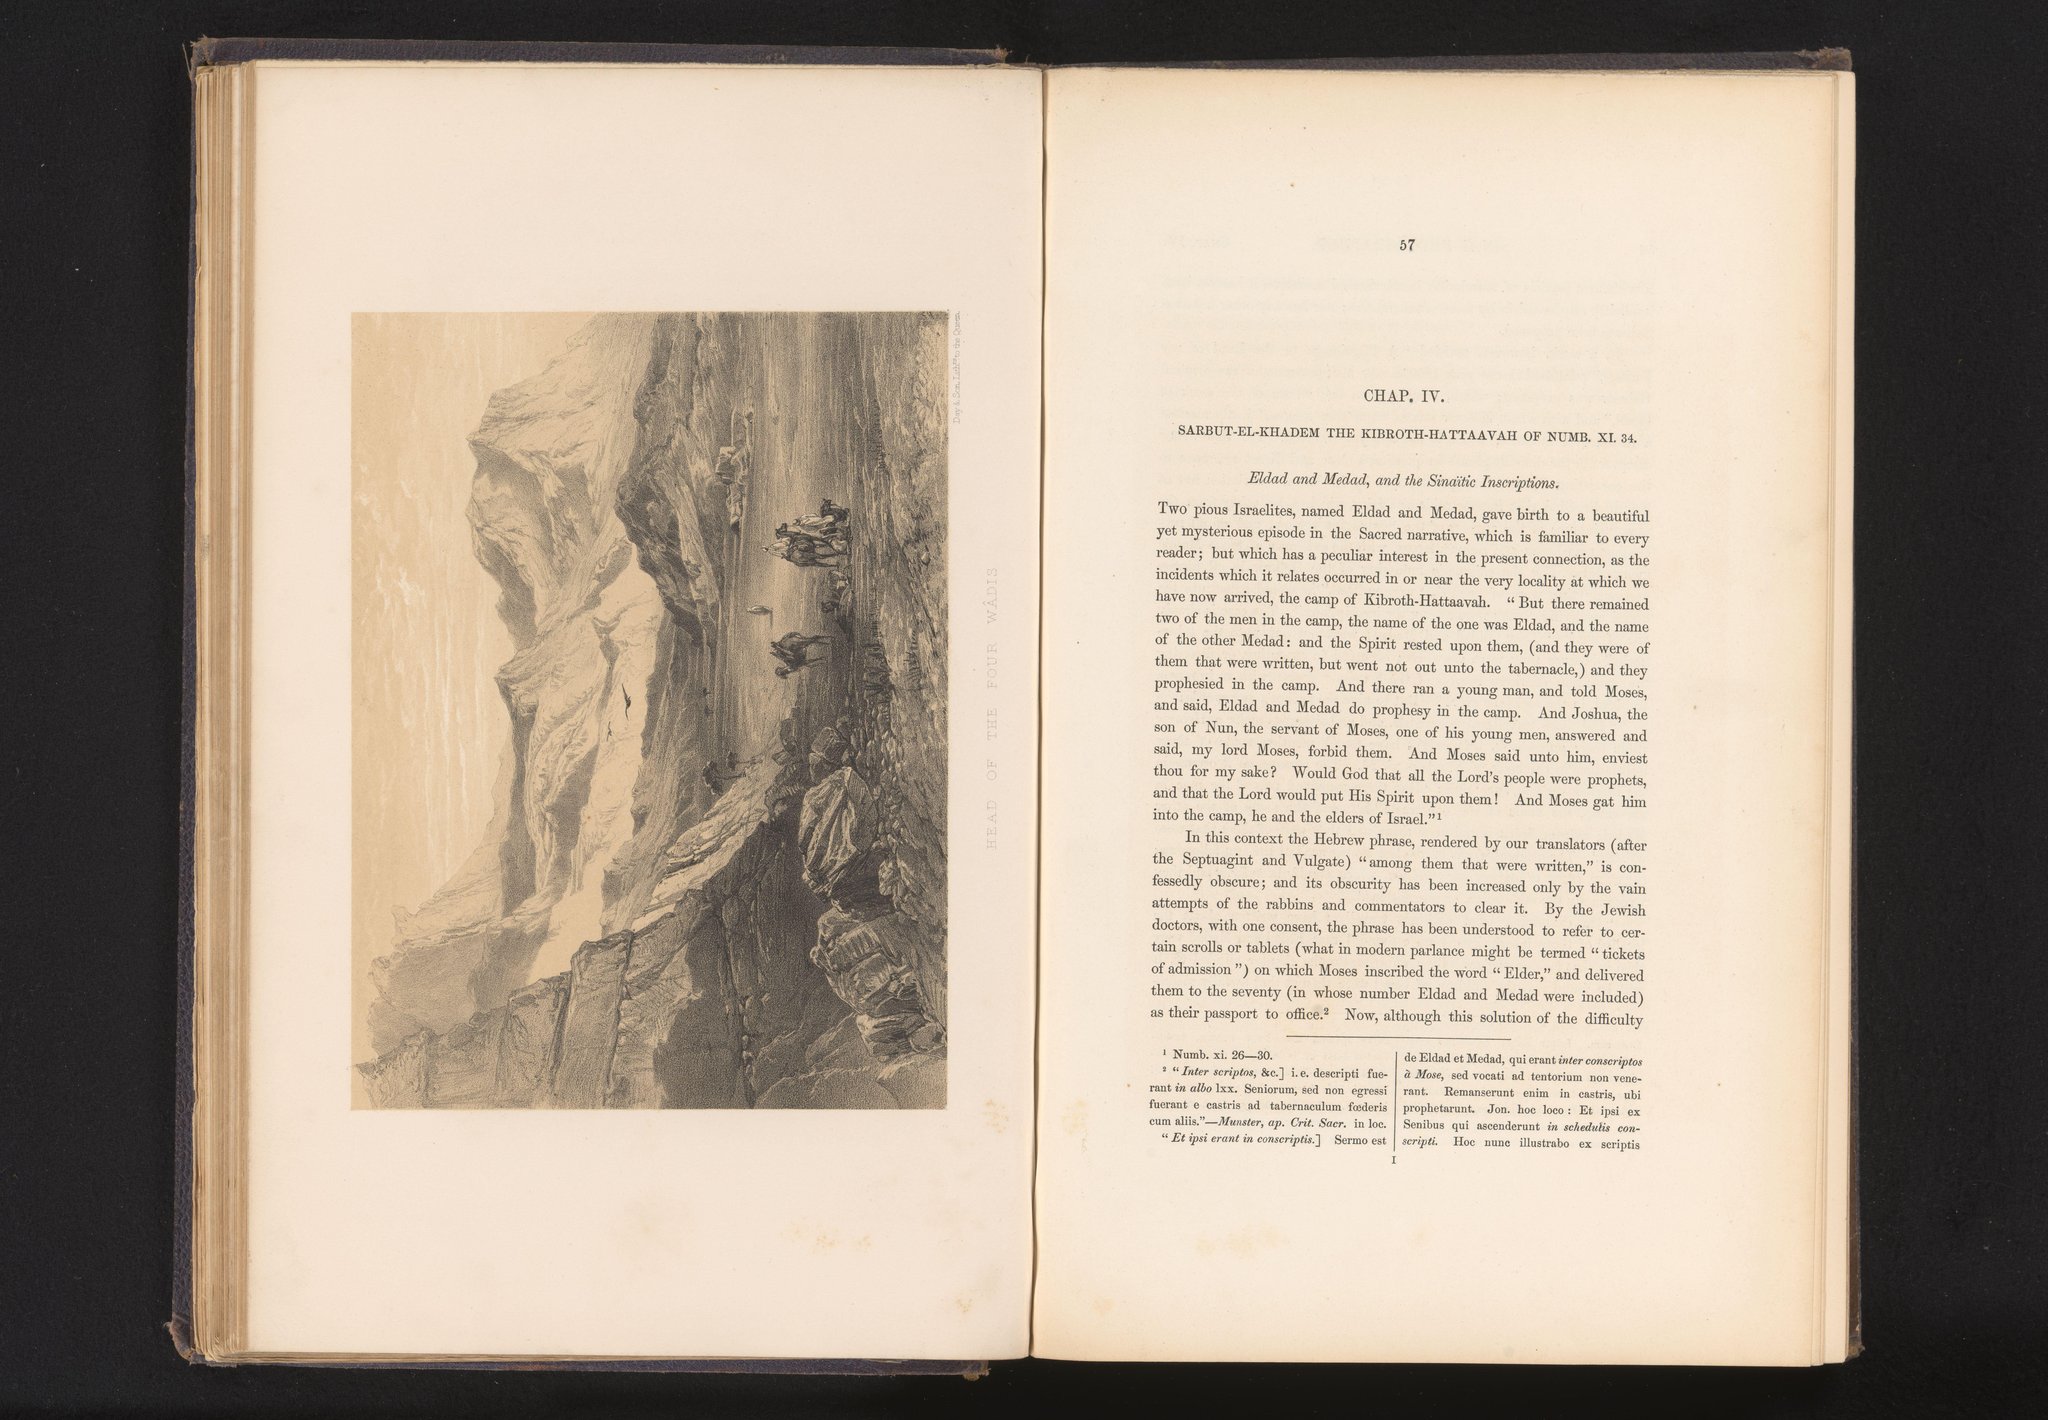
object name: print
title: Head of the four Wâdis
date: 1857-1862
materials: paper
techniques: tone lithography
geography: london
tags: mountains